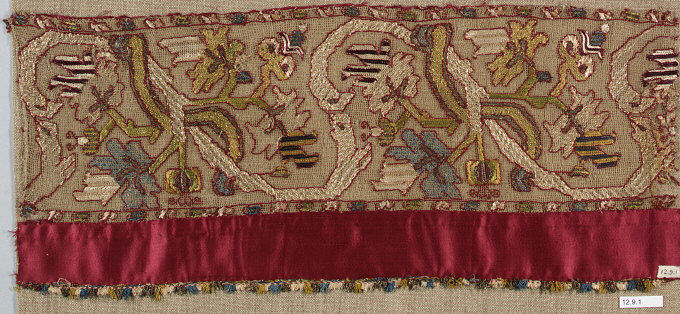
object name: strip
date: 1501-1700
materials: silk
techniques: embroidery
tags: leaves